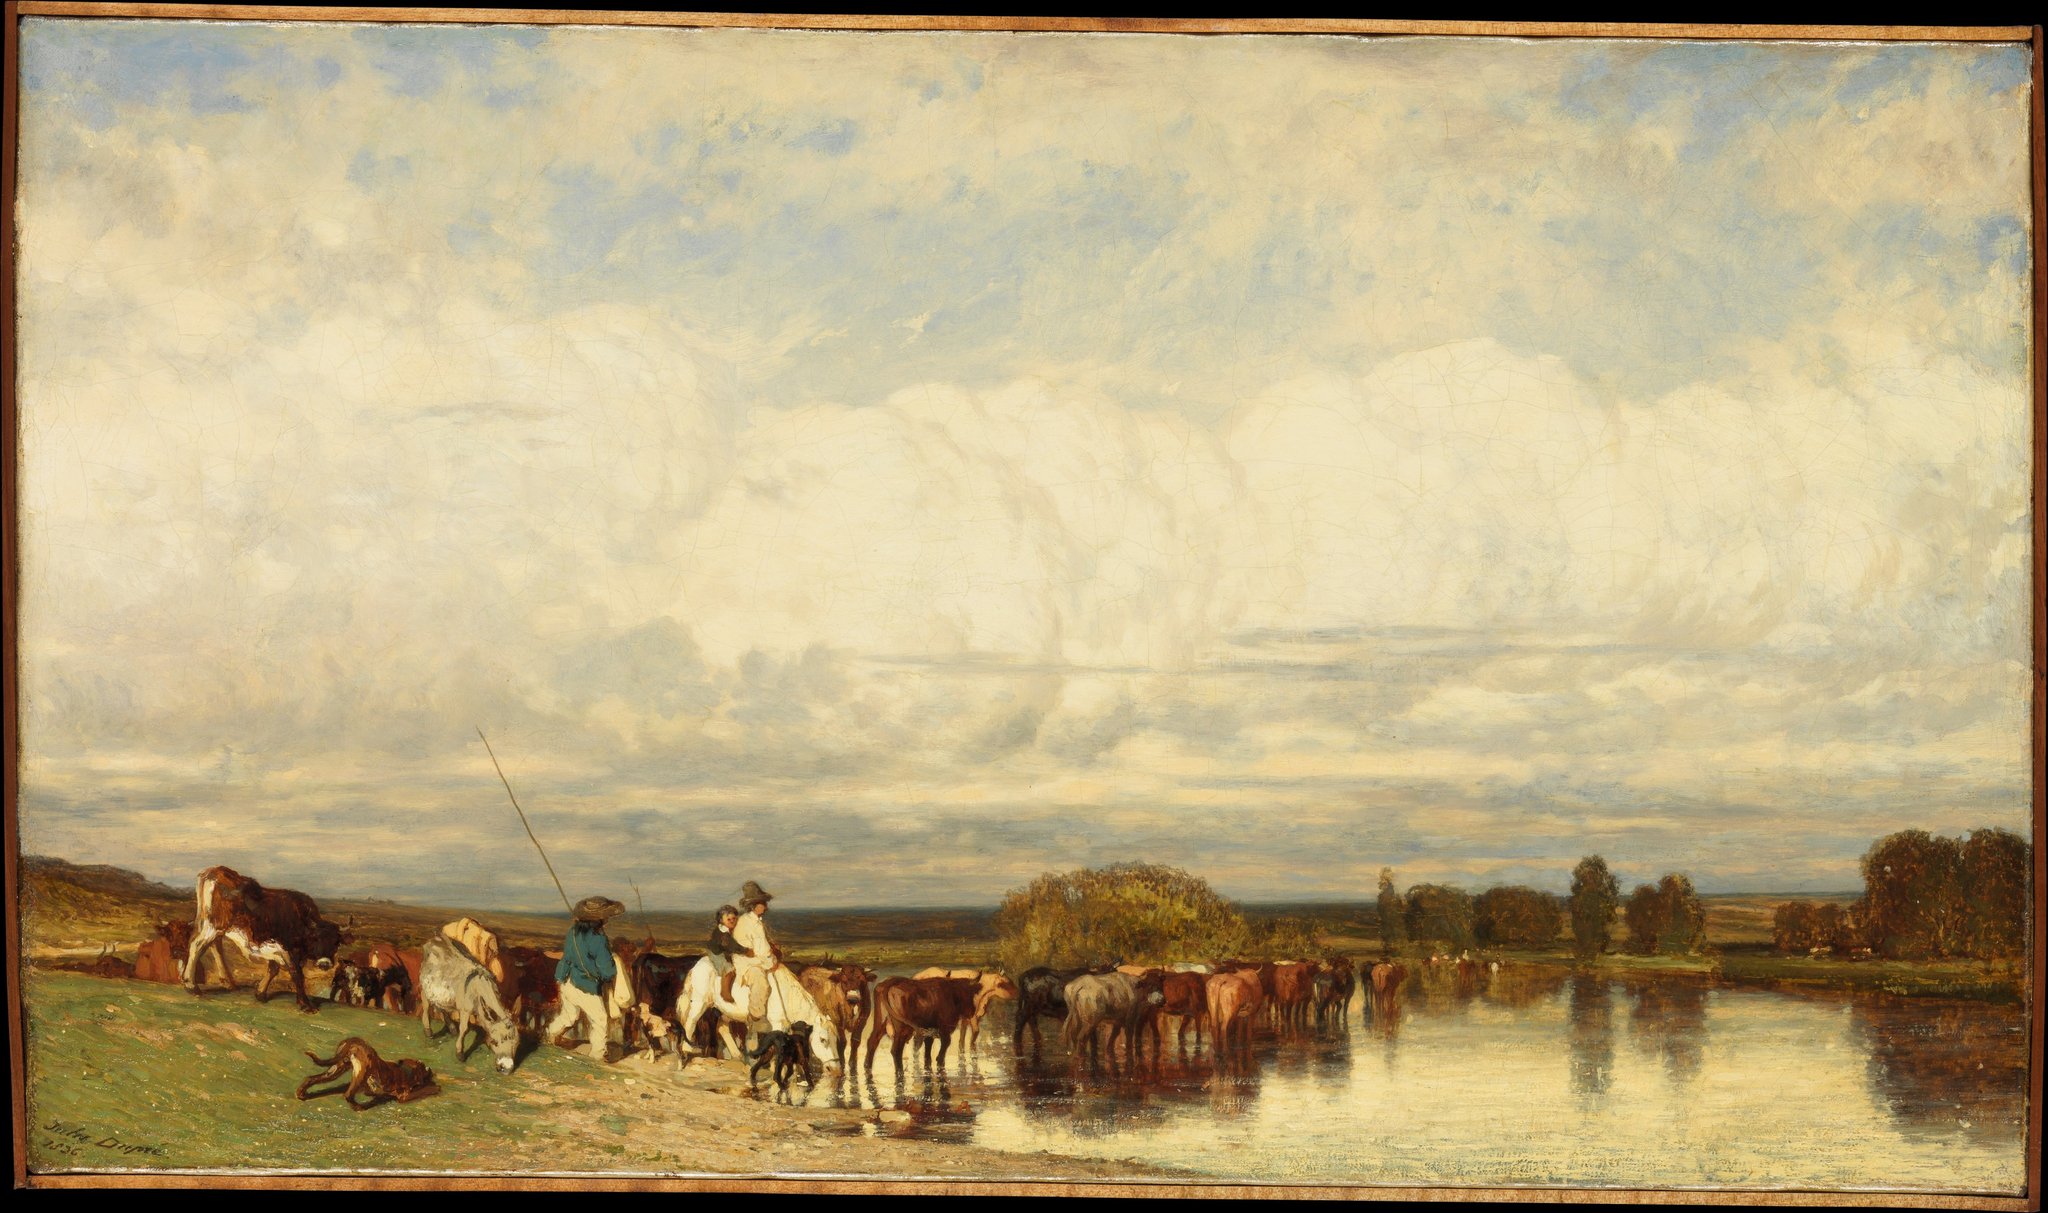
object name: painting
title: Cows Crossing a Ford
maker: jules dupré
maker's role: artist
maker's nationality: french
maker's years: 1811-1889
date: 1836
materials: canvas, oil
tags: cows,dogs,horses,rivers,landscapes